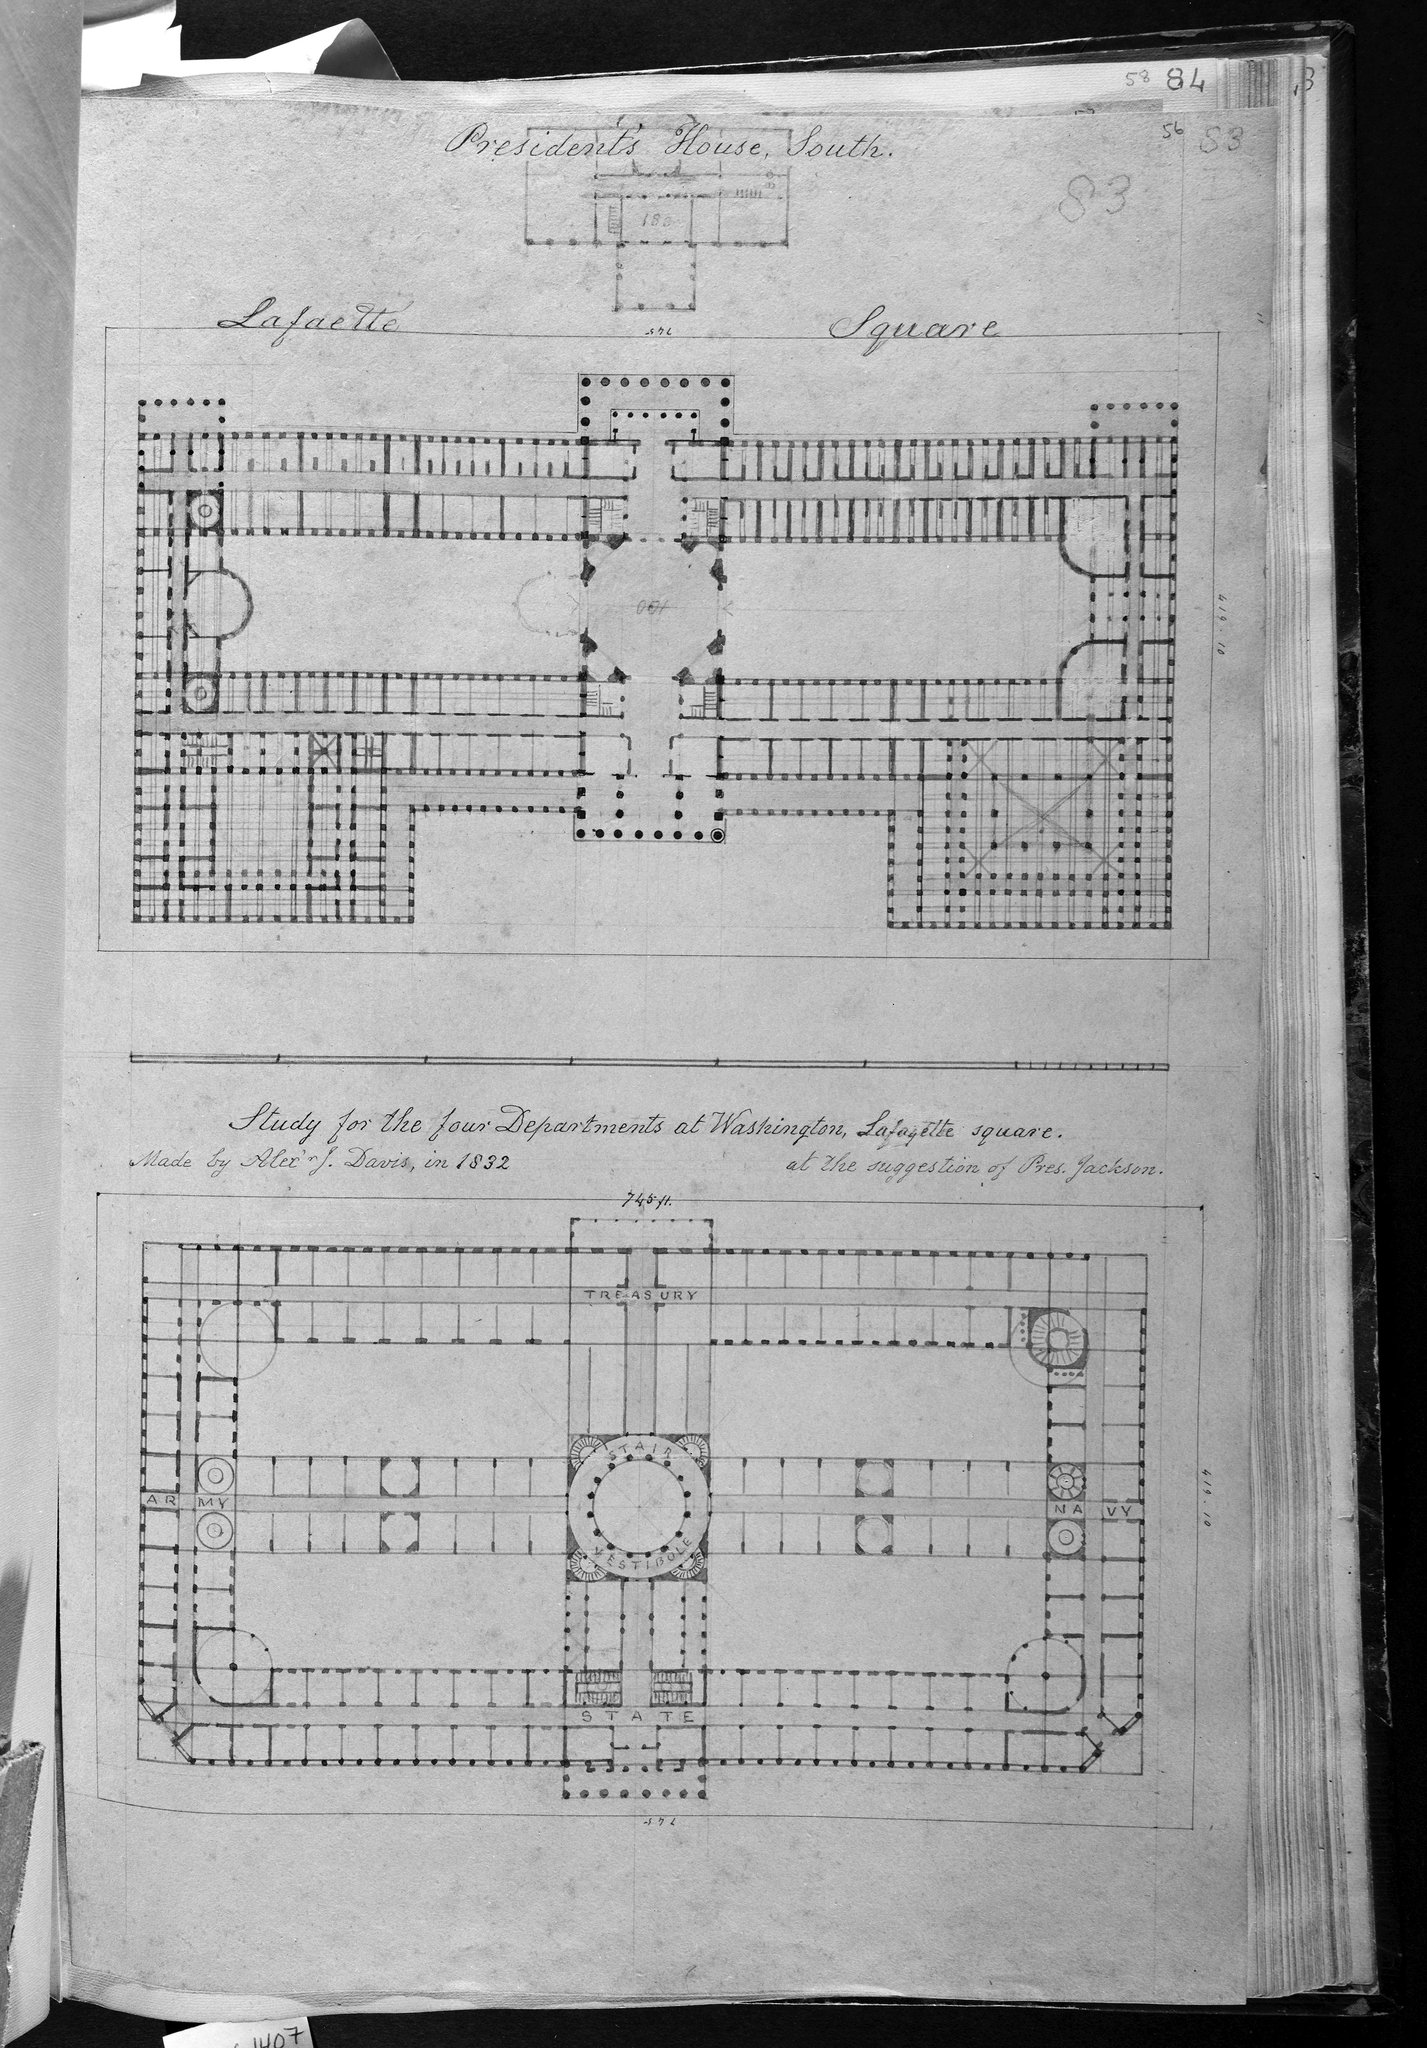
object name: album print ornament architecture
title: A. J. Davis, Scrapbook VIII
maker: alexander jackson davis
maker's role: artist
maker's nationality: american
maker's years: 1803-1892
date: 1835-1892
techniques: bookbinding, drawing